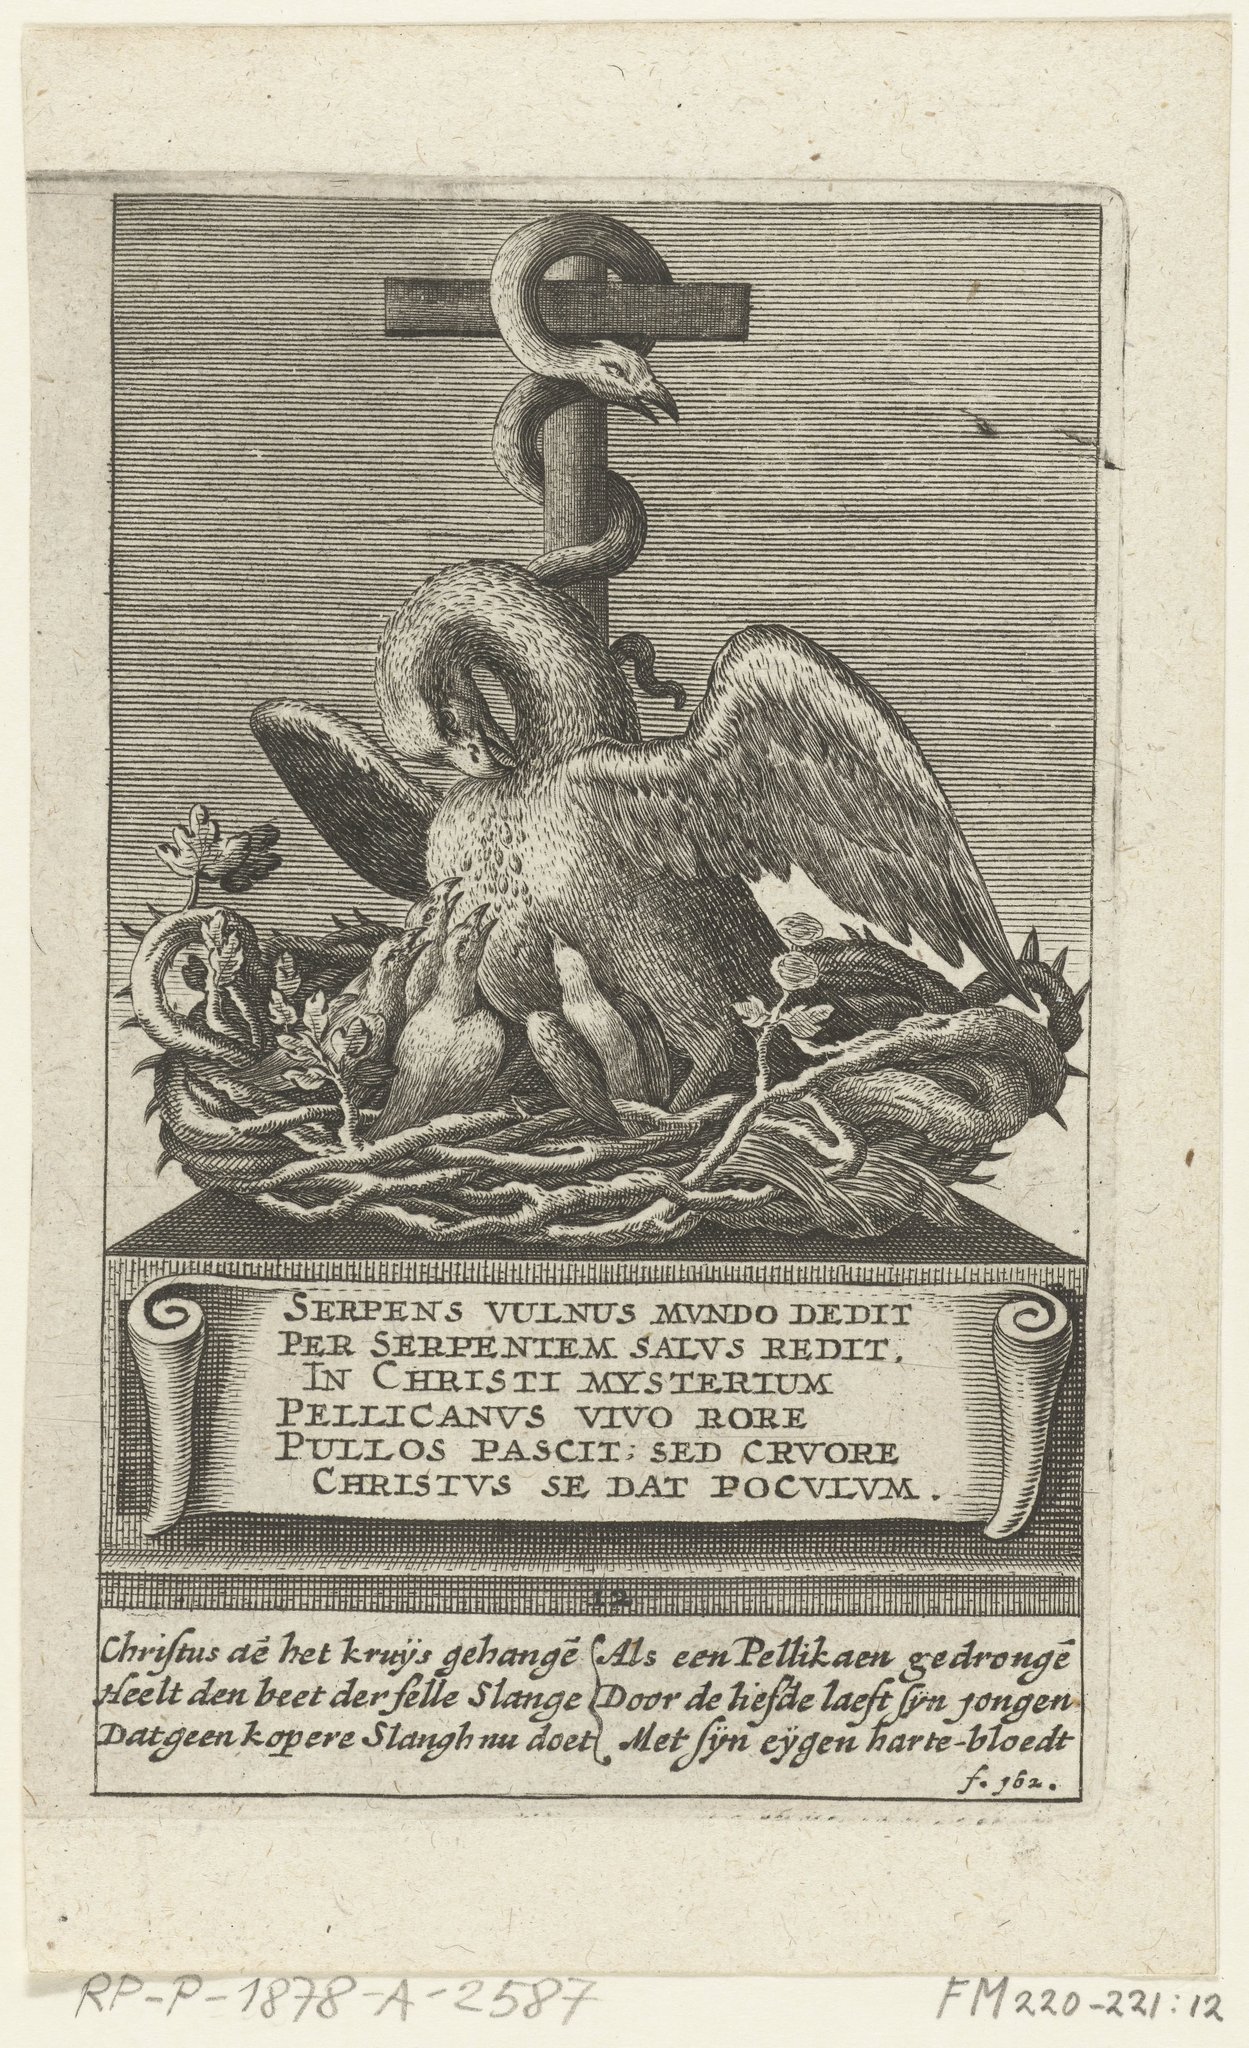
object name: print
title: Amstelredams eer ende opcomen door de denckwaerdighe miraklen aldaer geschied aen ende door het H. Sacrament des Altaers Anno 1345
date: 1639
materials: paper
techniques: engraving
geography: southern netherlands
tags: symbols of christ ~ animals, amsterdam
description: Allegorische embleem met de pelikaan die zich in de borst pikt om haar jongen met haar eigen bloed te voeden samen met de koperen slang om het kruis. Prent nr. 12 uit de serie van 16 voorstellingen van Het Mirakel van Amsterdam, naar de gebeurtenissen op 15 maart 1345. Onder de voorstelling twee zesregelige verzen in het Latijn en Nederlands.